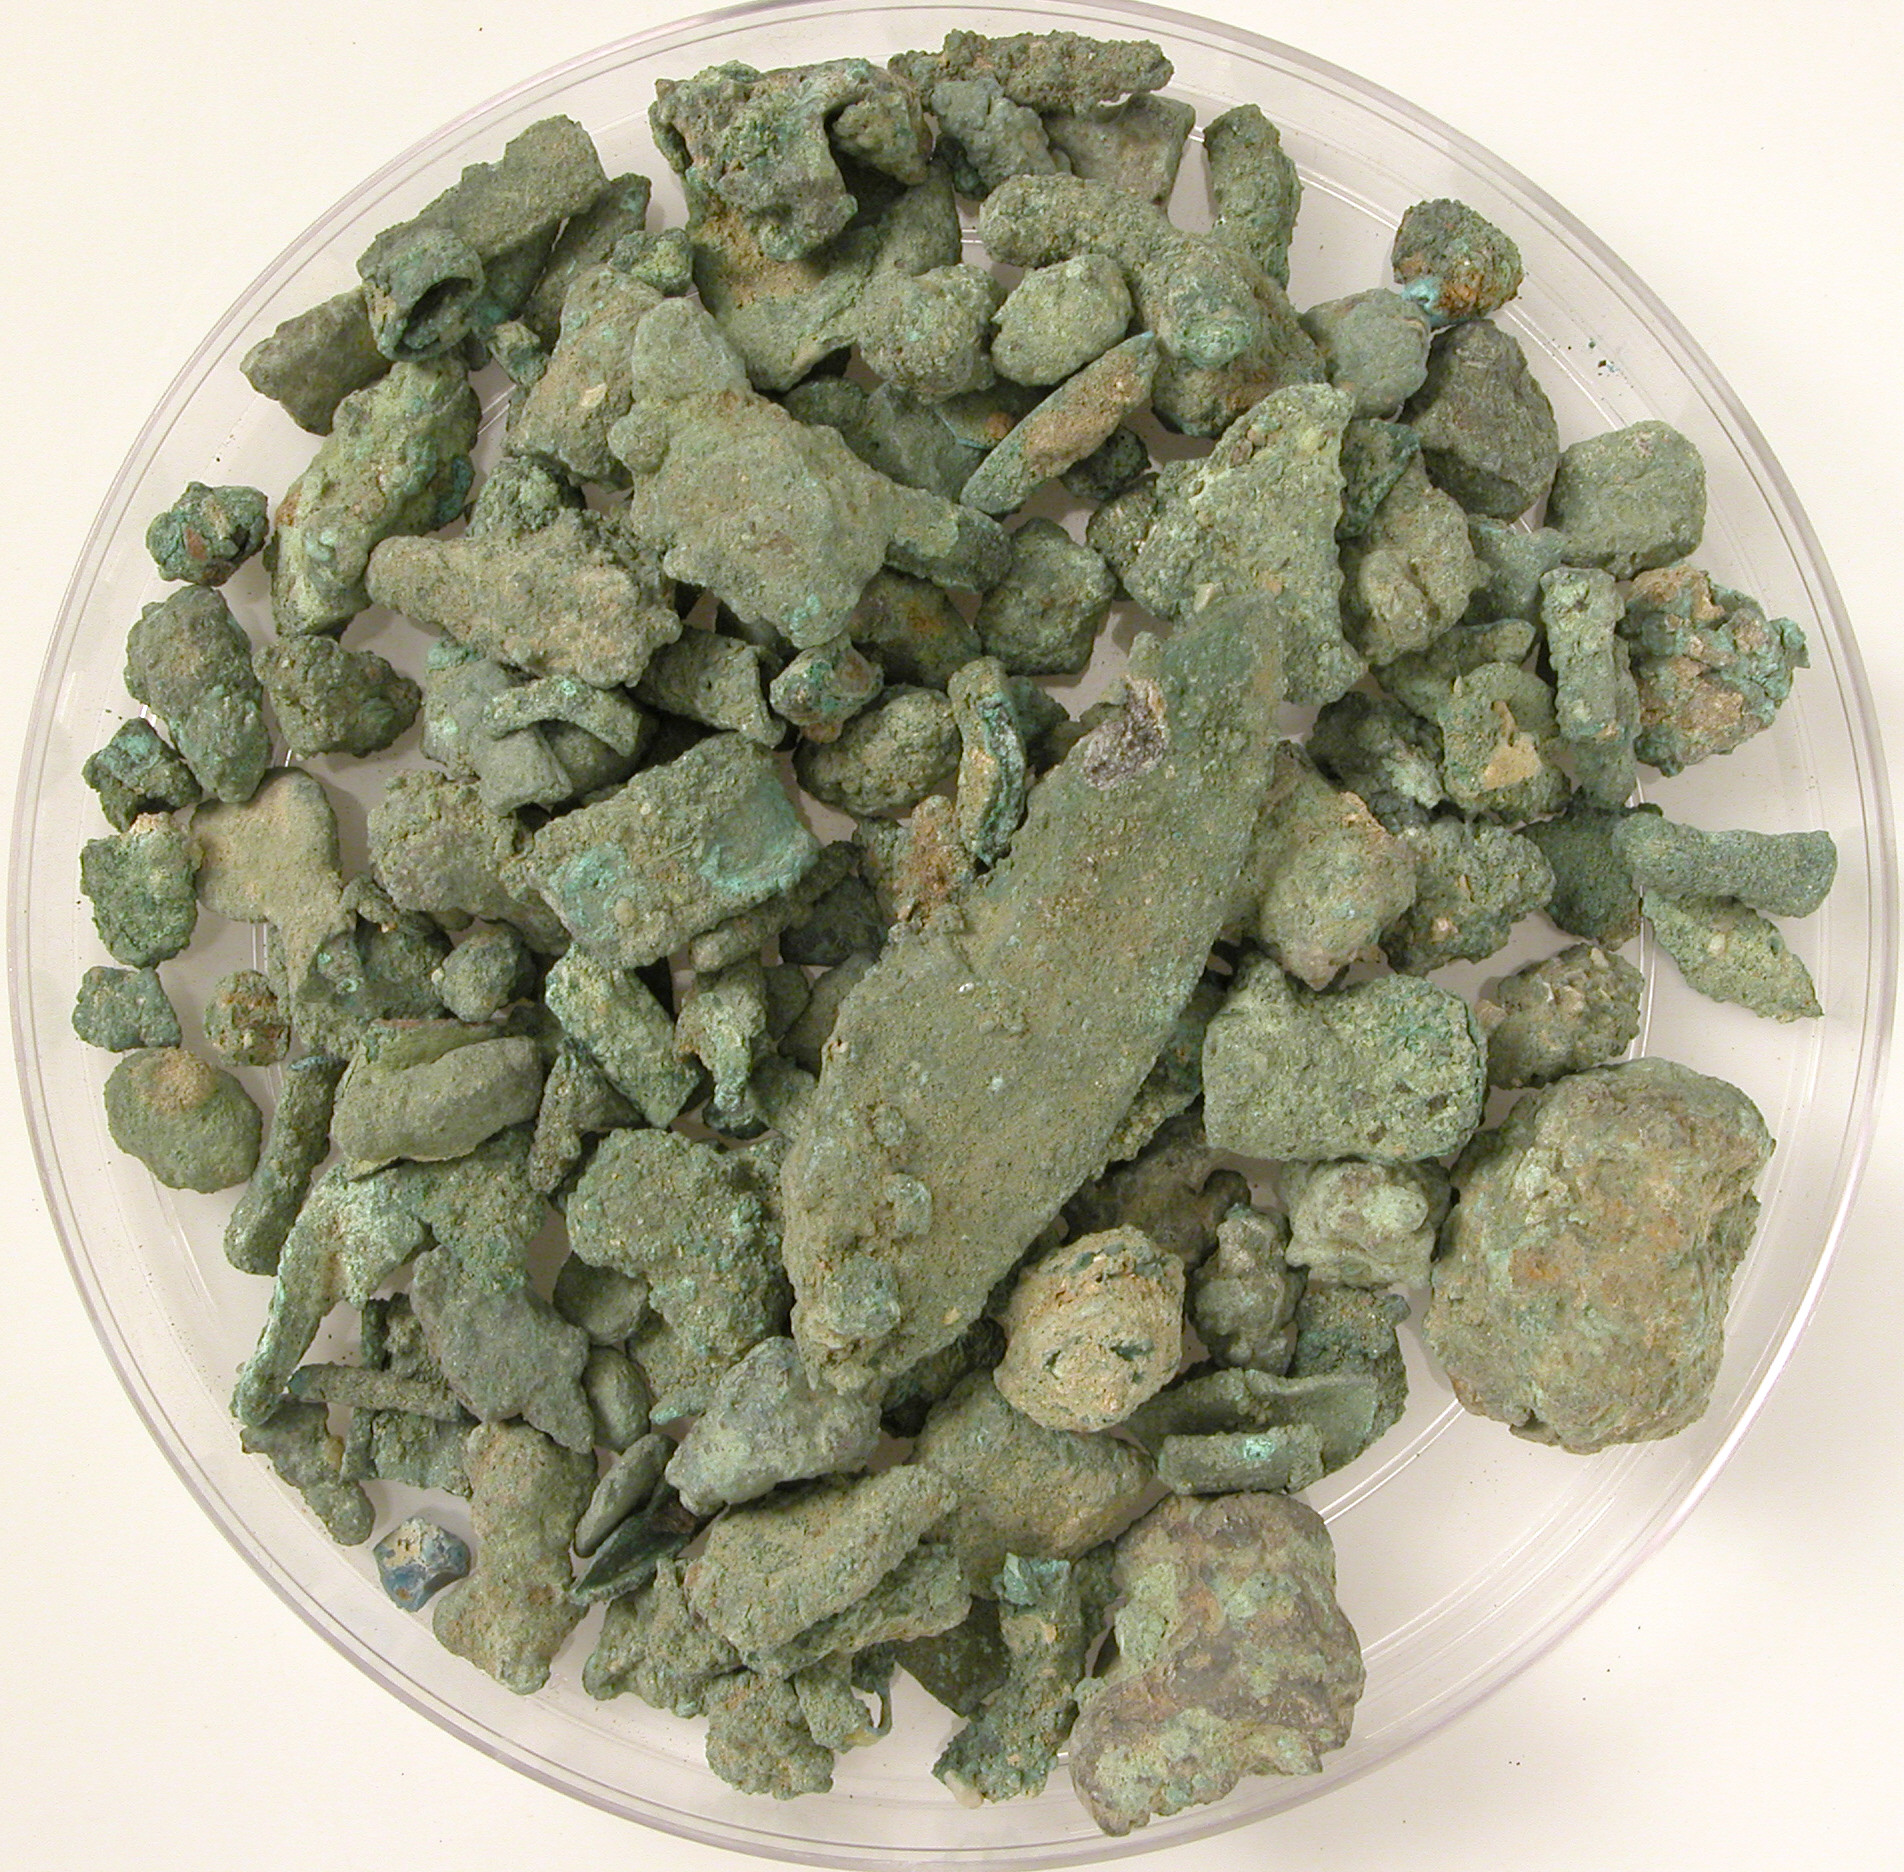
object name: fragment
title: Fragments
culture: coptic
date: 301-700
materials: copper alloy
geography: egypt